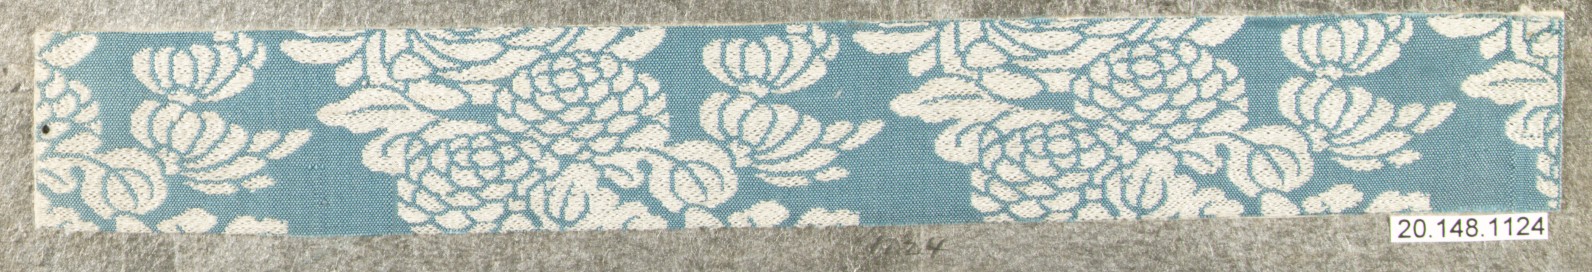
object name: piece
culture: japanese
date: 1701-1800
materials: silk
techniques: compound weave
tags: flowers